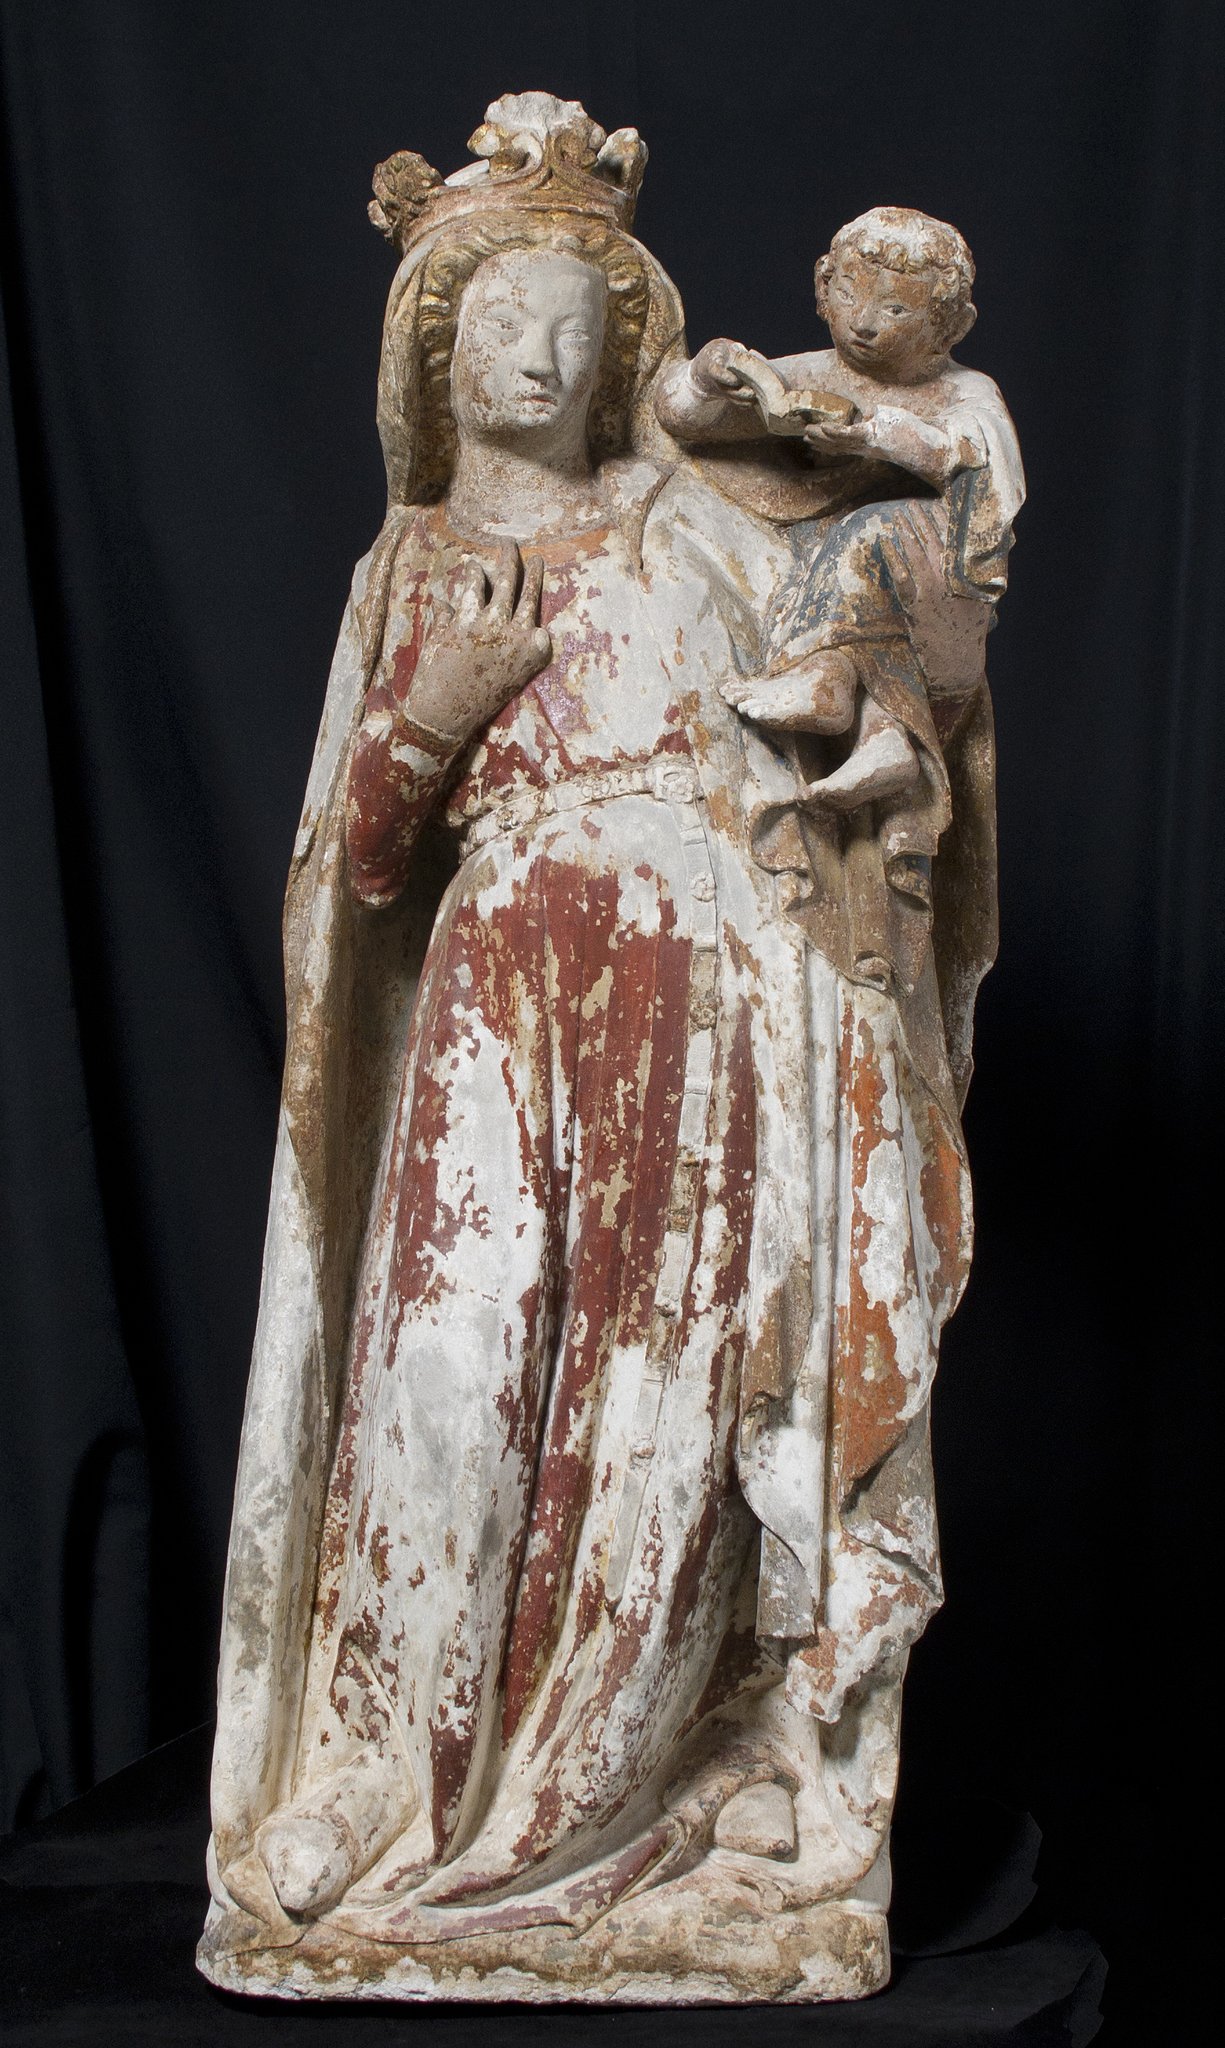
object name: statuette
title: Standing Virgin and Child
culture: french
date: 1301-1500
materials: paint, stone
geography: france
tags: madonna and child,virgin mary,jesus